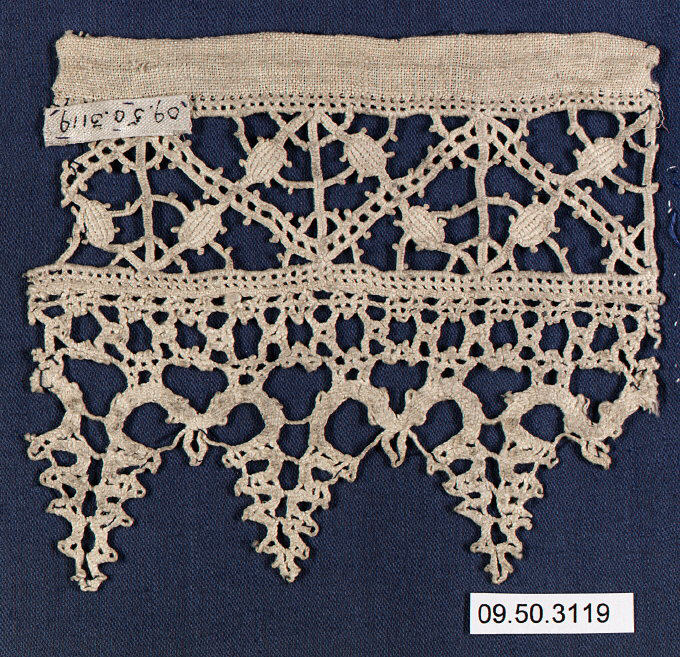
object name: strip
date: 1501-1700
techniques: lace